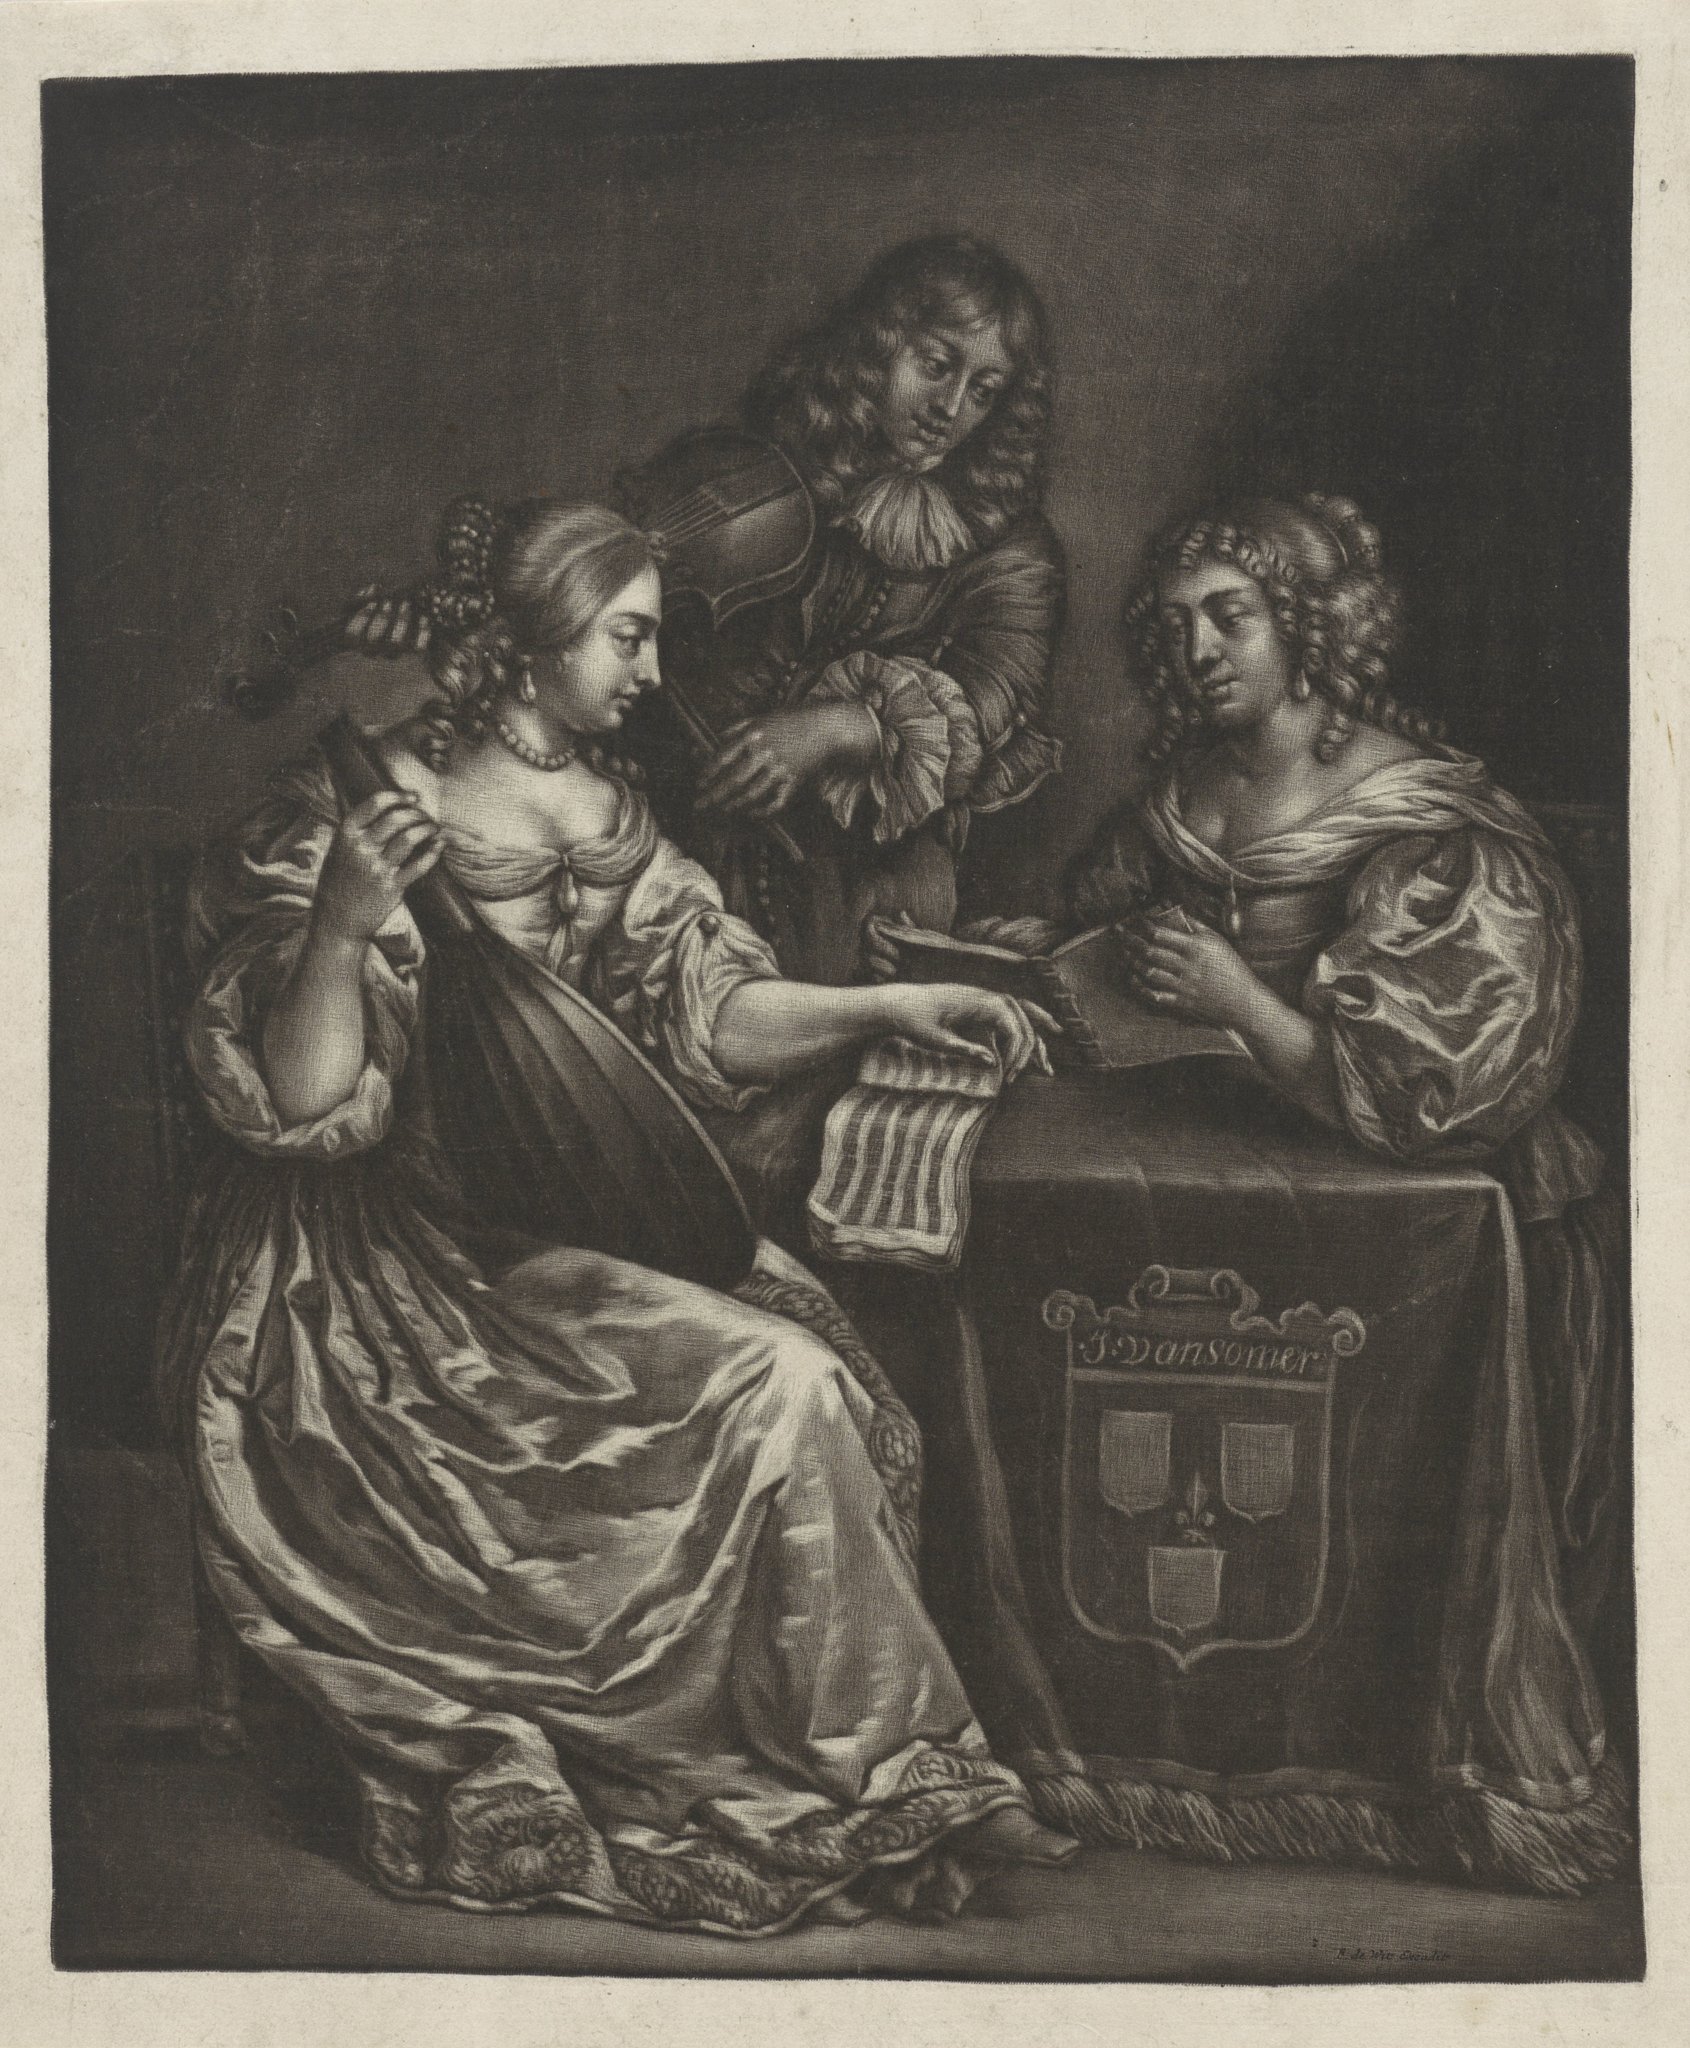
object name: print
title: Musicerend trio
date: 1655-1706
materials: paper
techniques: mezzotint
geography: amsterdam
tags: violin, fiddle, vocal music, singing, more than one musician with instrument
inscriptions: collector's mark: Lugt 2228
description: Twee vrouwen en een man maken samen muziek. Er wordt gezongen en viool en luit gespeelt.